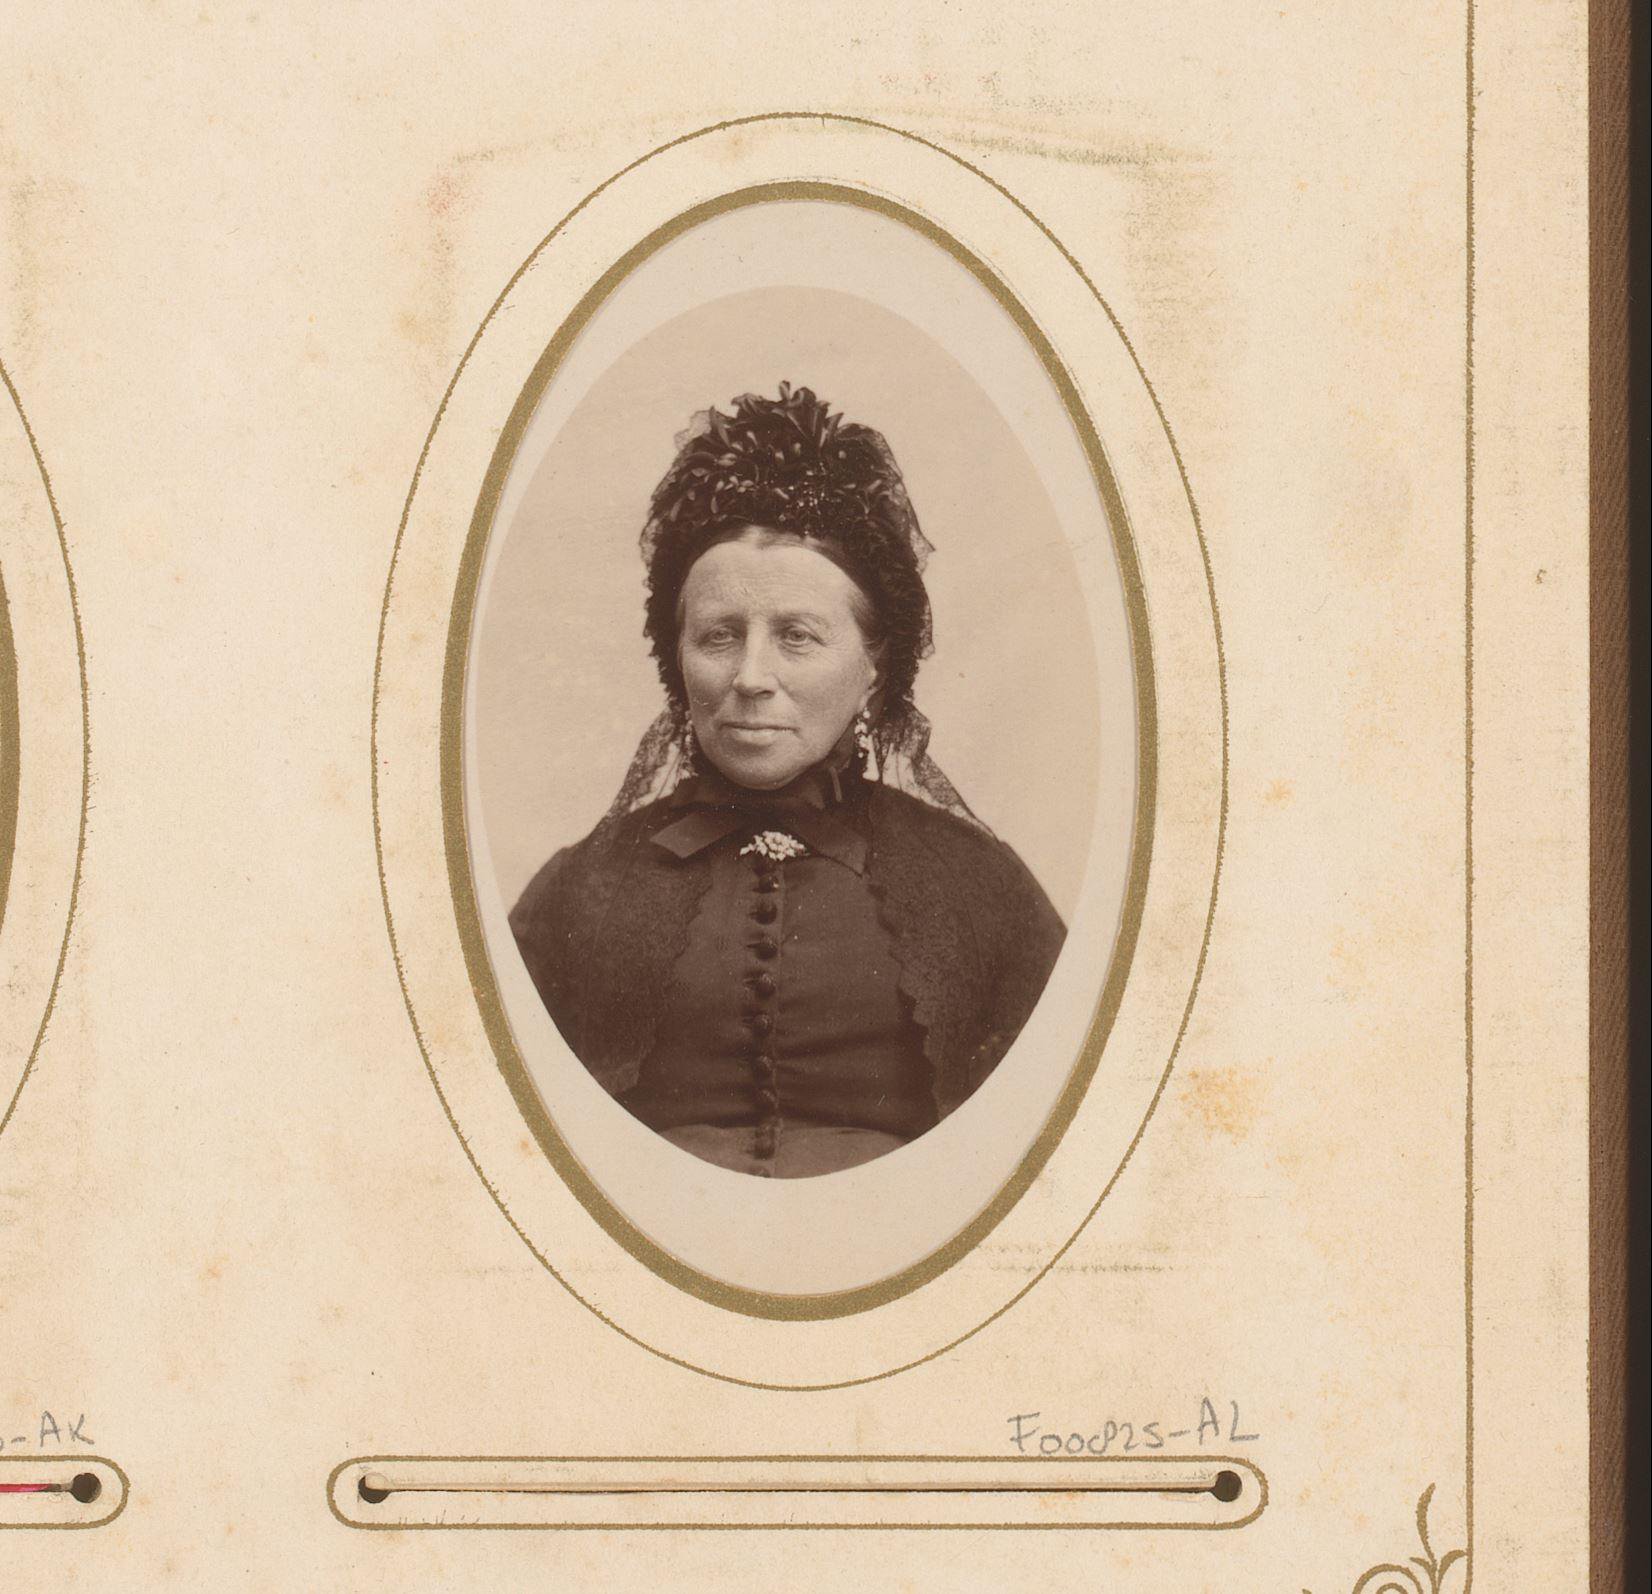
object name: carte de visite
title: Portret van een vrouw met muts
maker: august ferdinand heinrich harms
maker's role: fotograaf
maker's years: 1845-1916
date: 1884-1900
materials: cardboard, photographic support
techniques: albumen print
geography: haarlem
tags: historical persons - bb - woman, head-gear: cap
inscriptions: inscription: ‘A.F.H. Harms/ Haarlem/ Zylweg 75.’